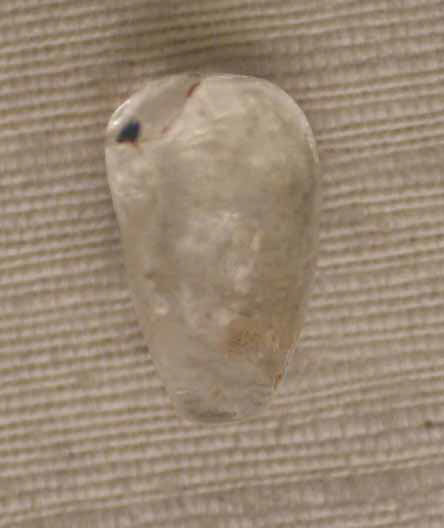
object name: seal or bead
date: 701-1300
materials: quartz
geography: iran